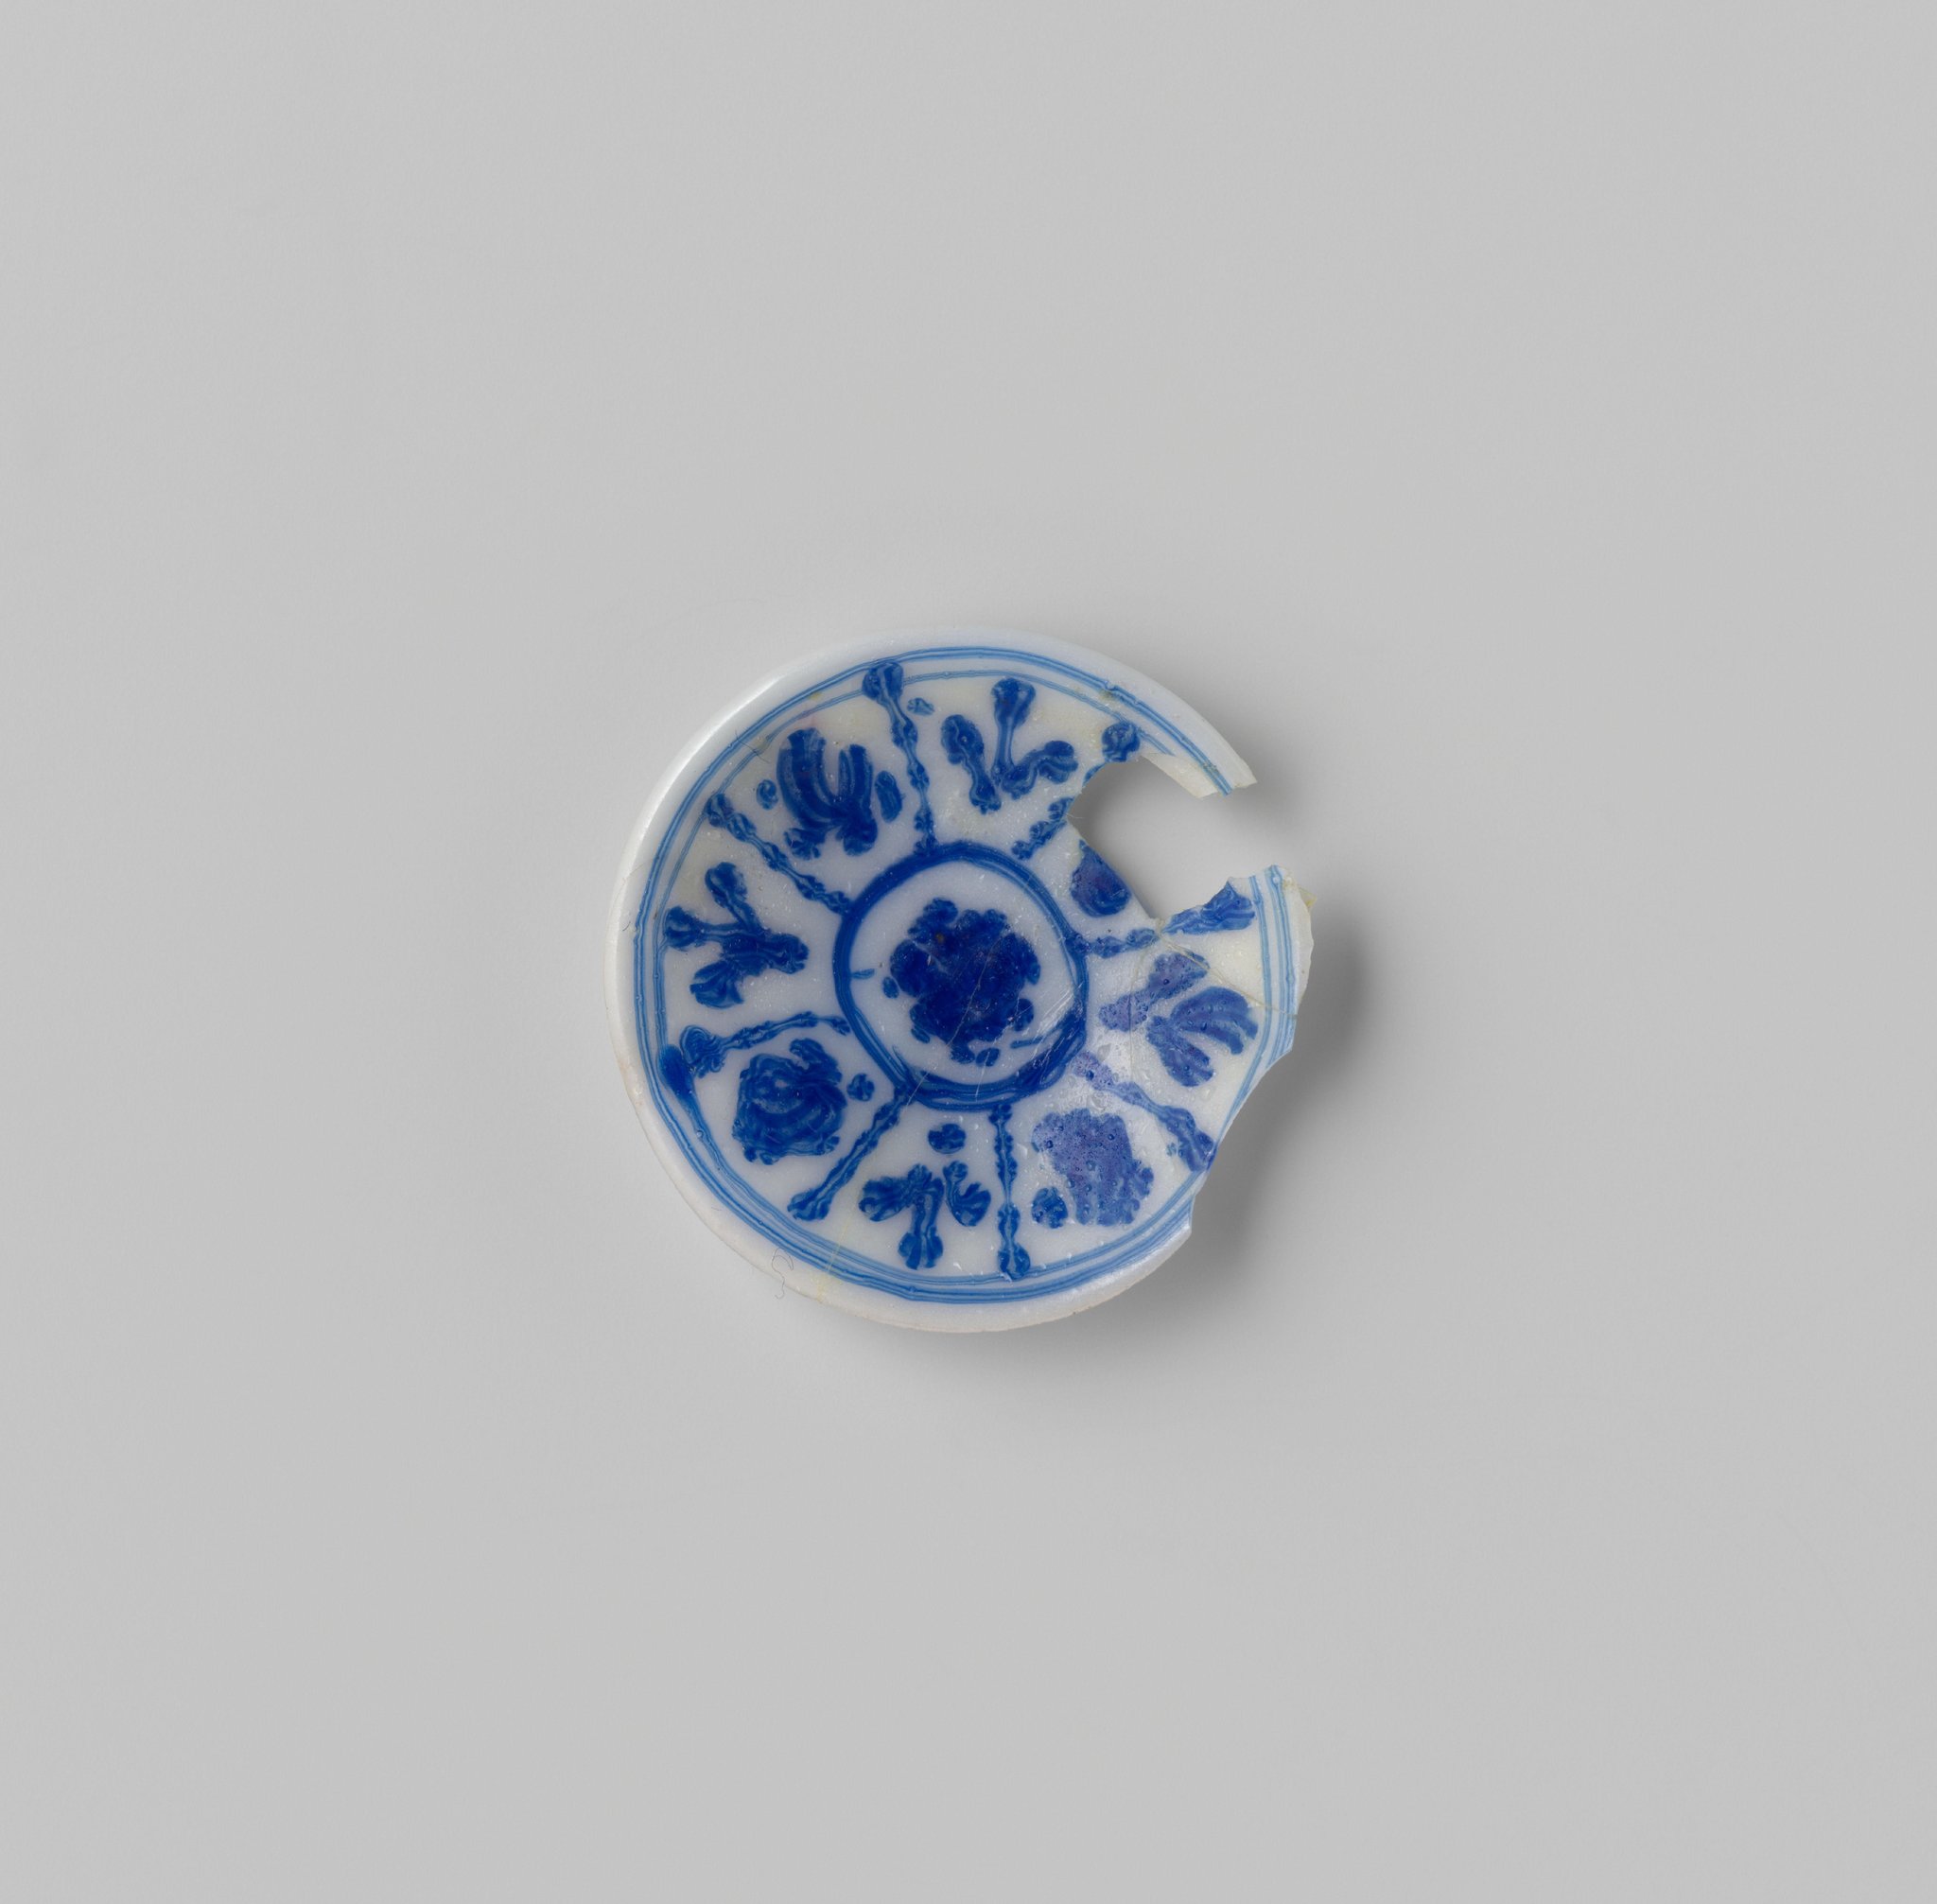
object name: platter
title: Schotel van melkglas met blauwe emailverf beschildering, imitatie Chinees porselein; bloemmotieven in vakken in Kraakporselein stijl; dubbelwandig met gladde rand.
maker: Anonymous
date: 1675-1710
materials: glass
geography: amsterdam